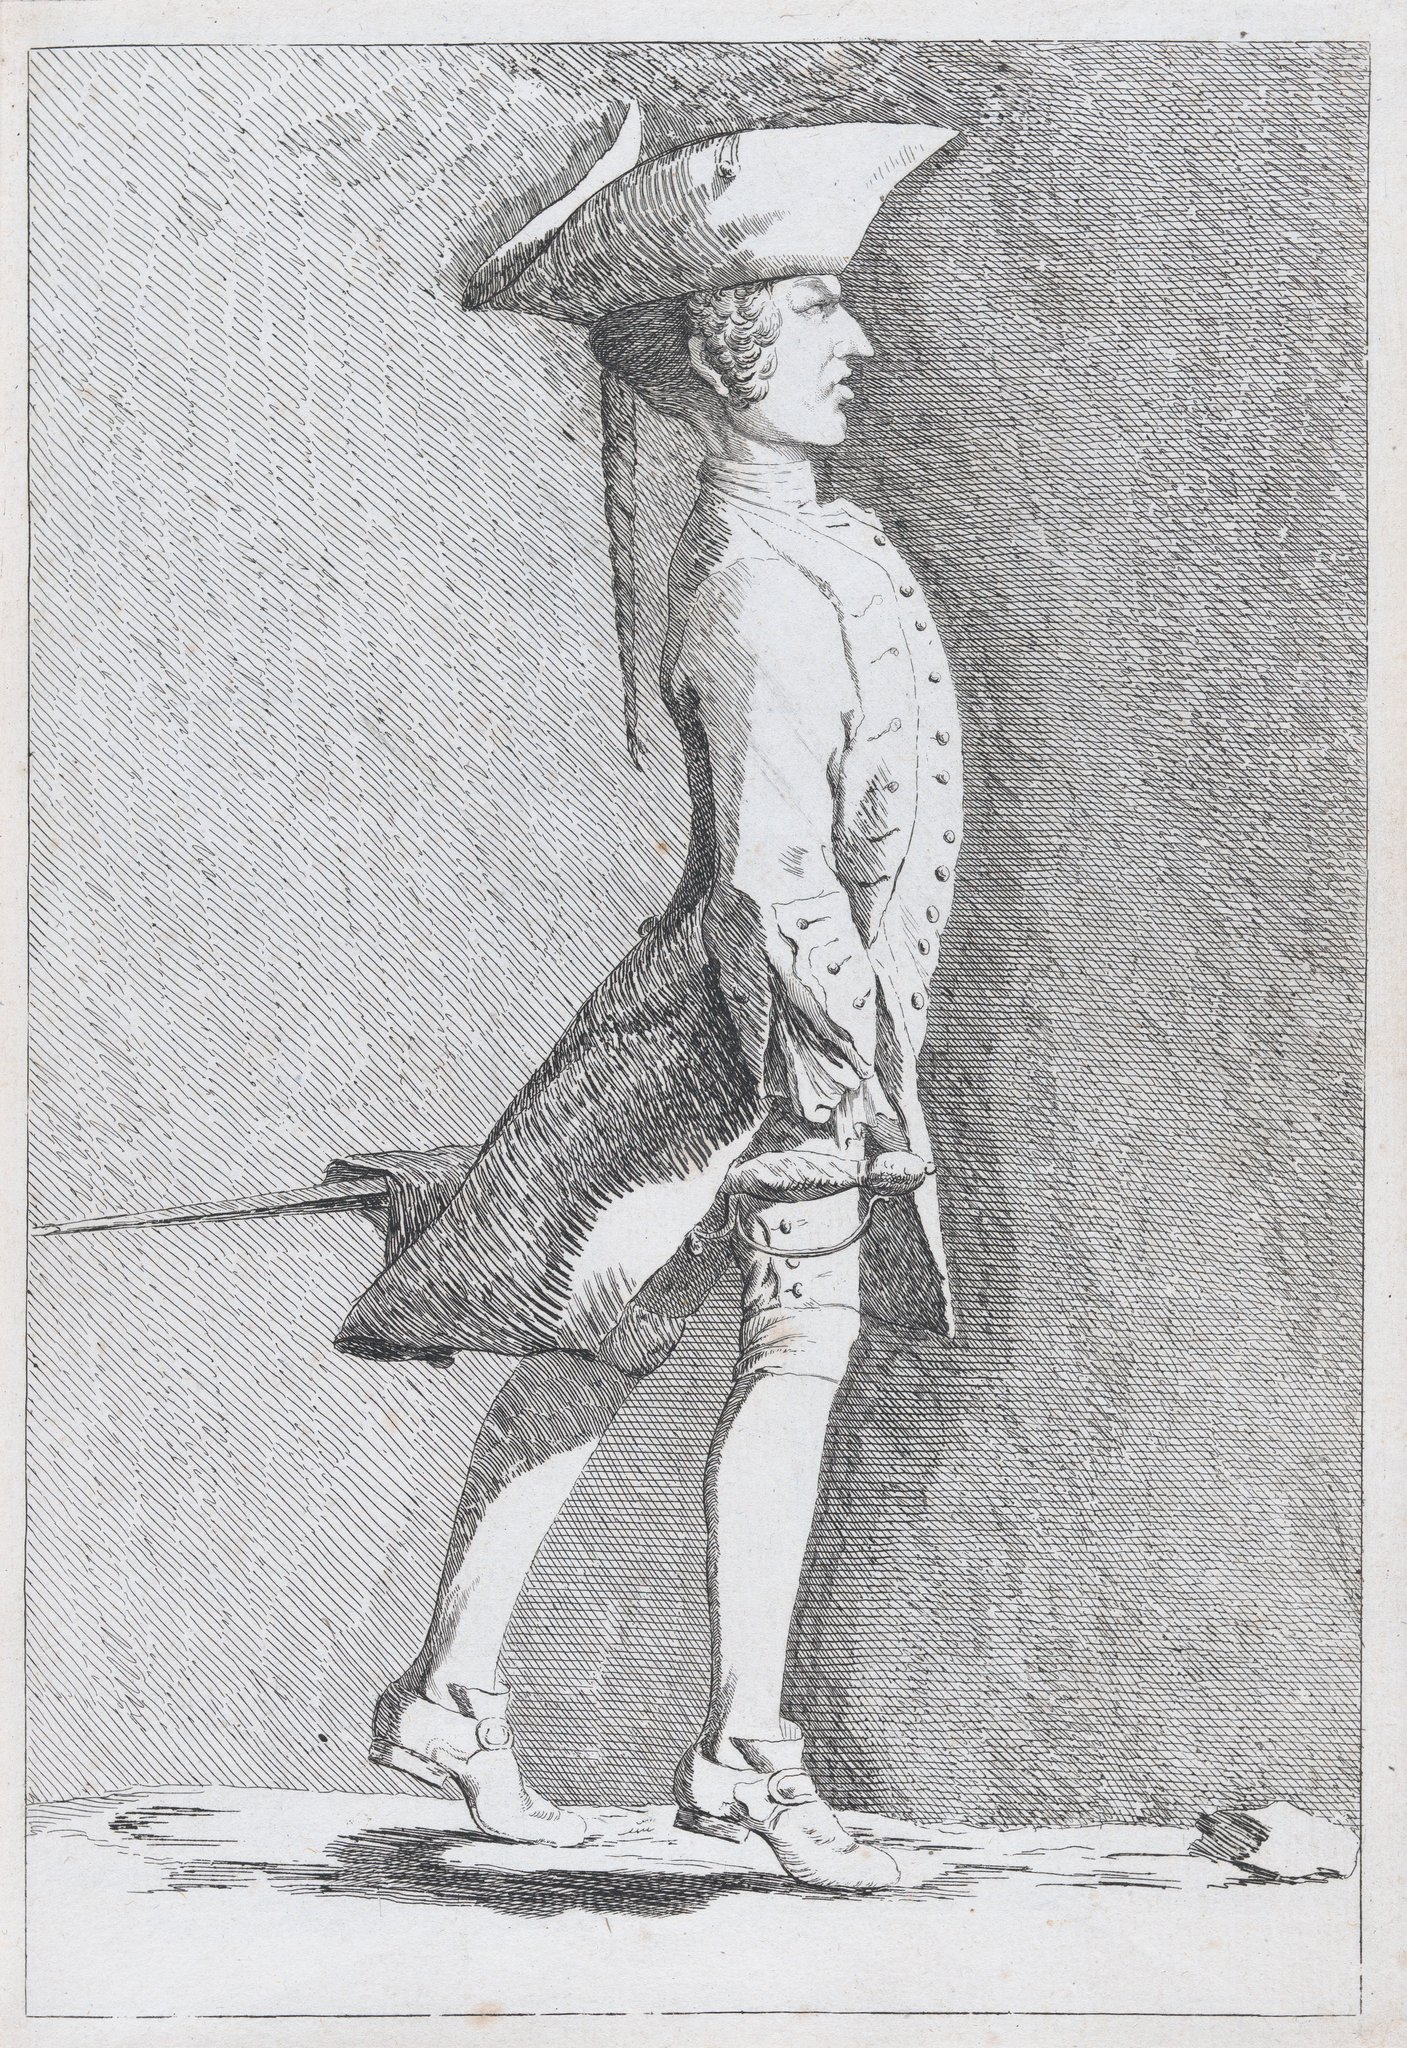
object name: print, album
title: Louis-Joseph le Lorrain (?), pl. IV from "Recueil de caricatures"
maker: ange-laurent de la live de jully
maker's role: artist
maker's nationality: french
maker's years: 1725-1779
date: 1754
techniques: etching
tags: men,caricature